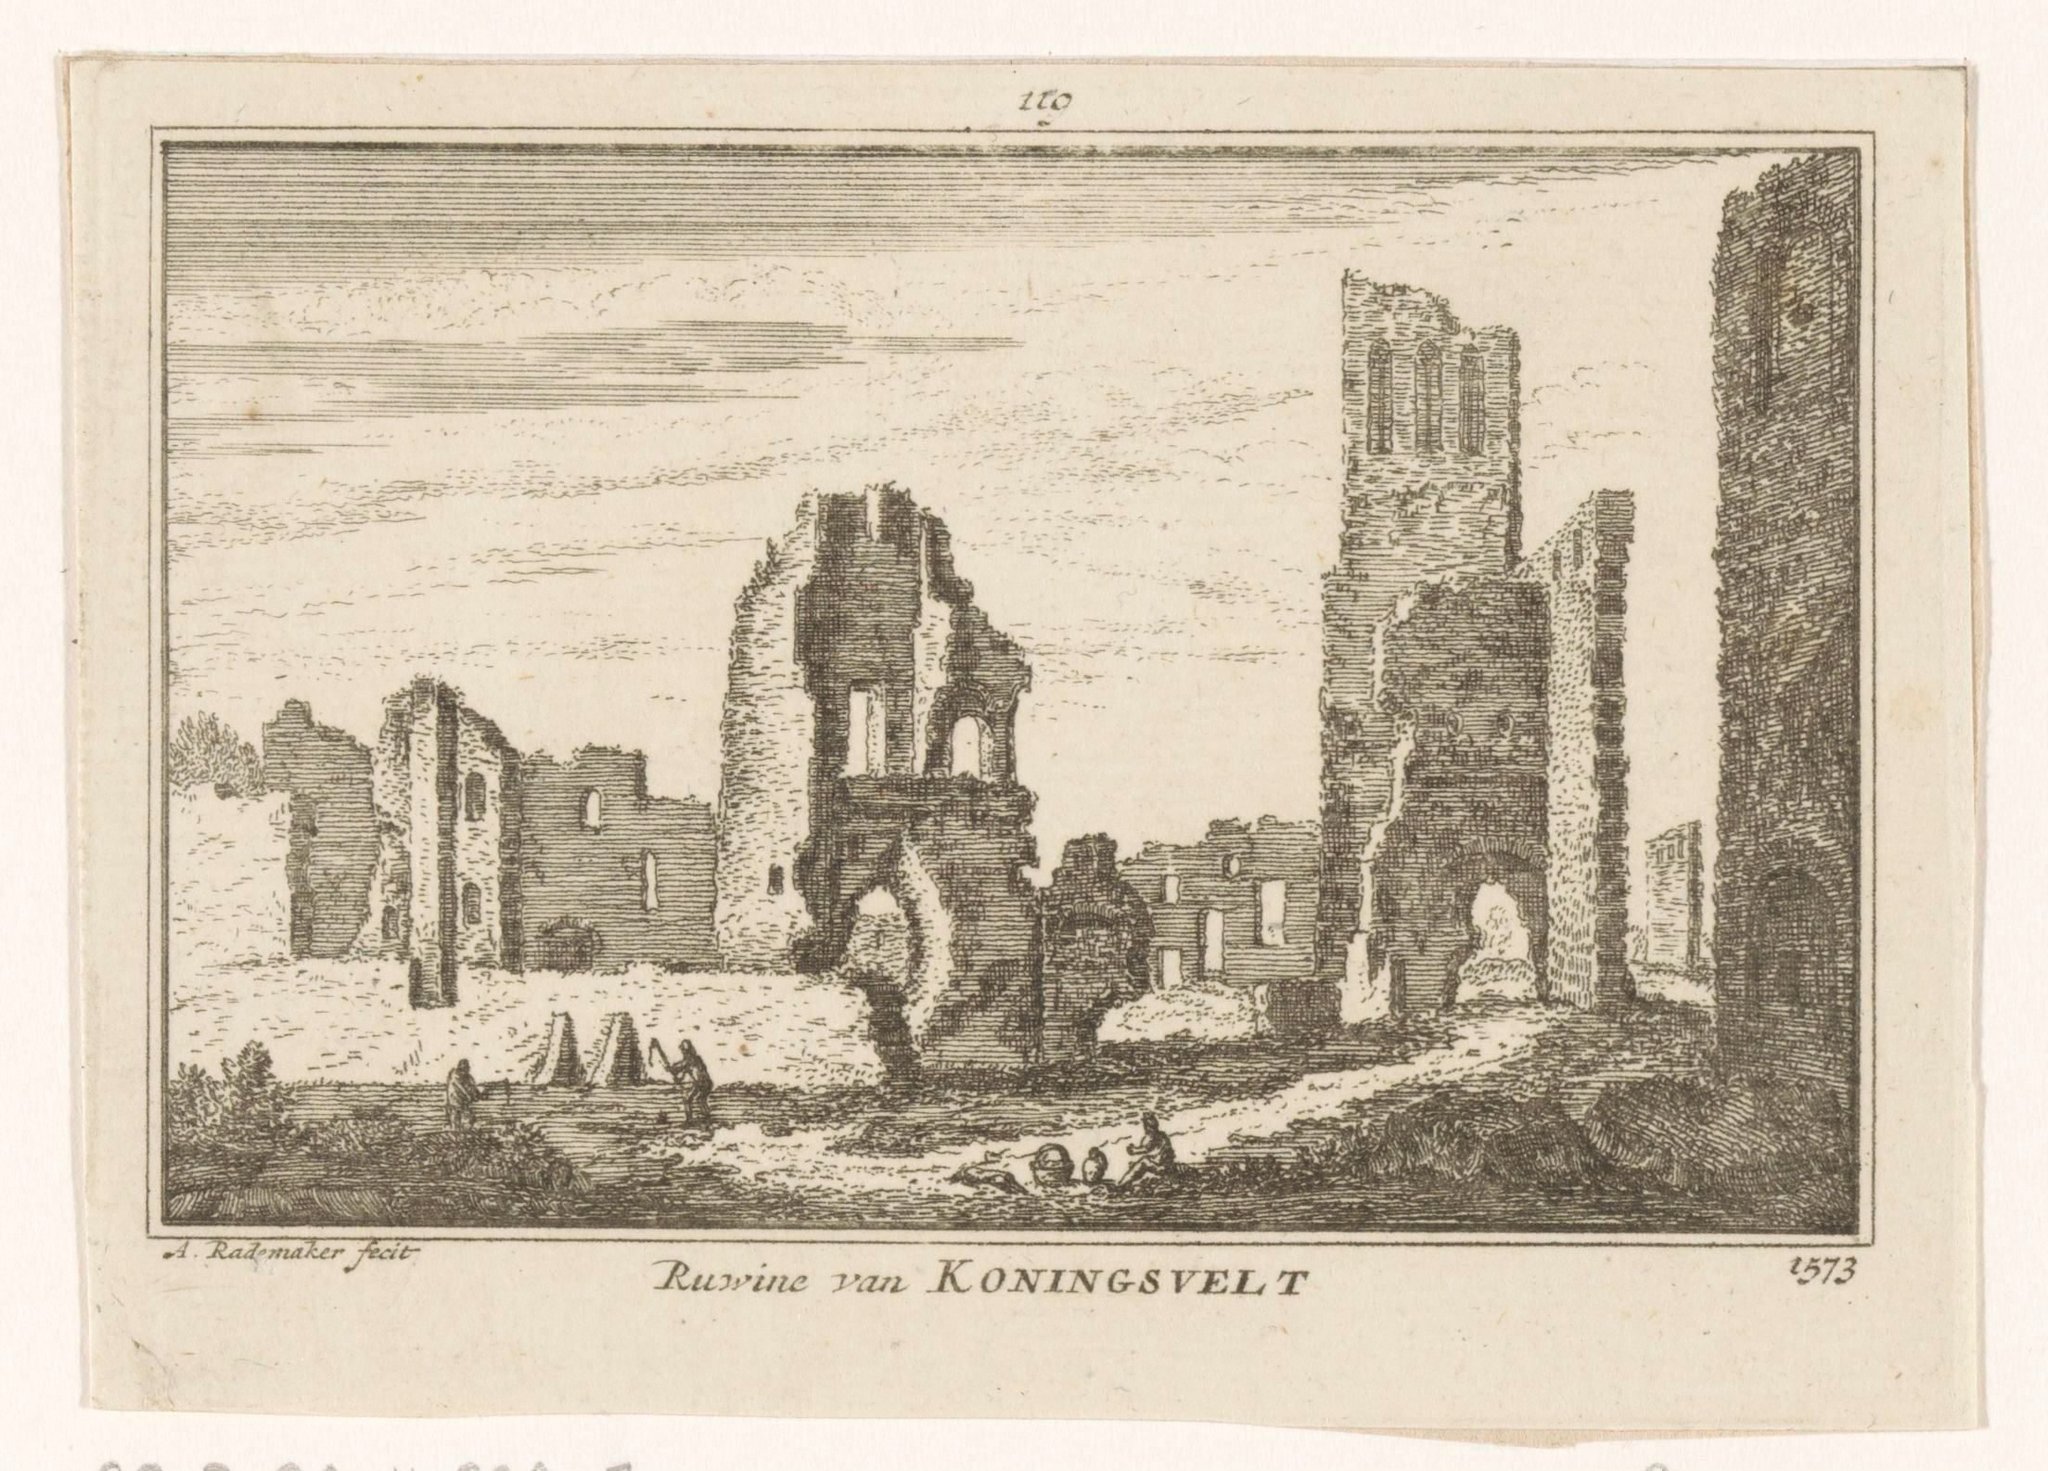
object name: print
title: Ruwine van Koningsvelt 1573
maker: abraham rademaker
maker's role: draughtsman, print maker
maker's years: 1676-1735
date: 1725-1803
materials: paper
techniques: engraving, etching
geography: amsterdam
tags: ruin of church, monastery, etc., fisherman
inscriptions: collector's mark: Lugt 2228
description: Prent ook gebruikt in: Rademaker, Abraham. Kabinet van Nederlandsche outheden en gezichten: vervat in 300 konstplaaten (…). 2 delen. Amsterdam: Willem Barents, 1725, dl. 1, ill. 119. Na 1725 is deze prent nog in verschillende heruitgaven verschenen, uitgegeven in 1727-1733, 1770-1771 en 1792-1803. Uit welke uitgave het huidige exemplaar precies komt is niet na te gaan.